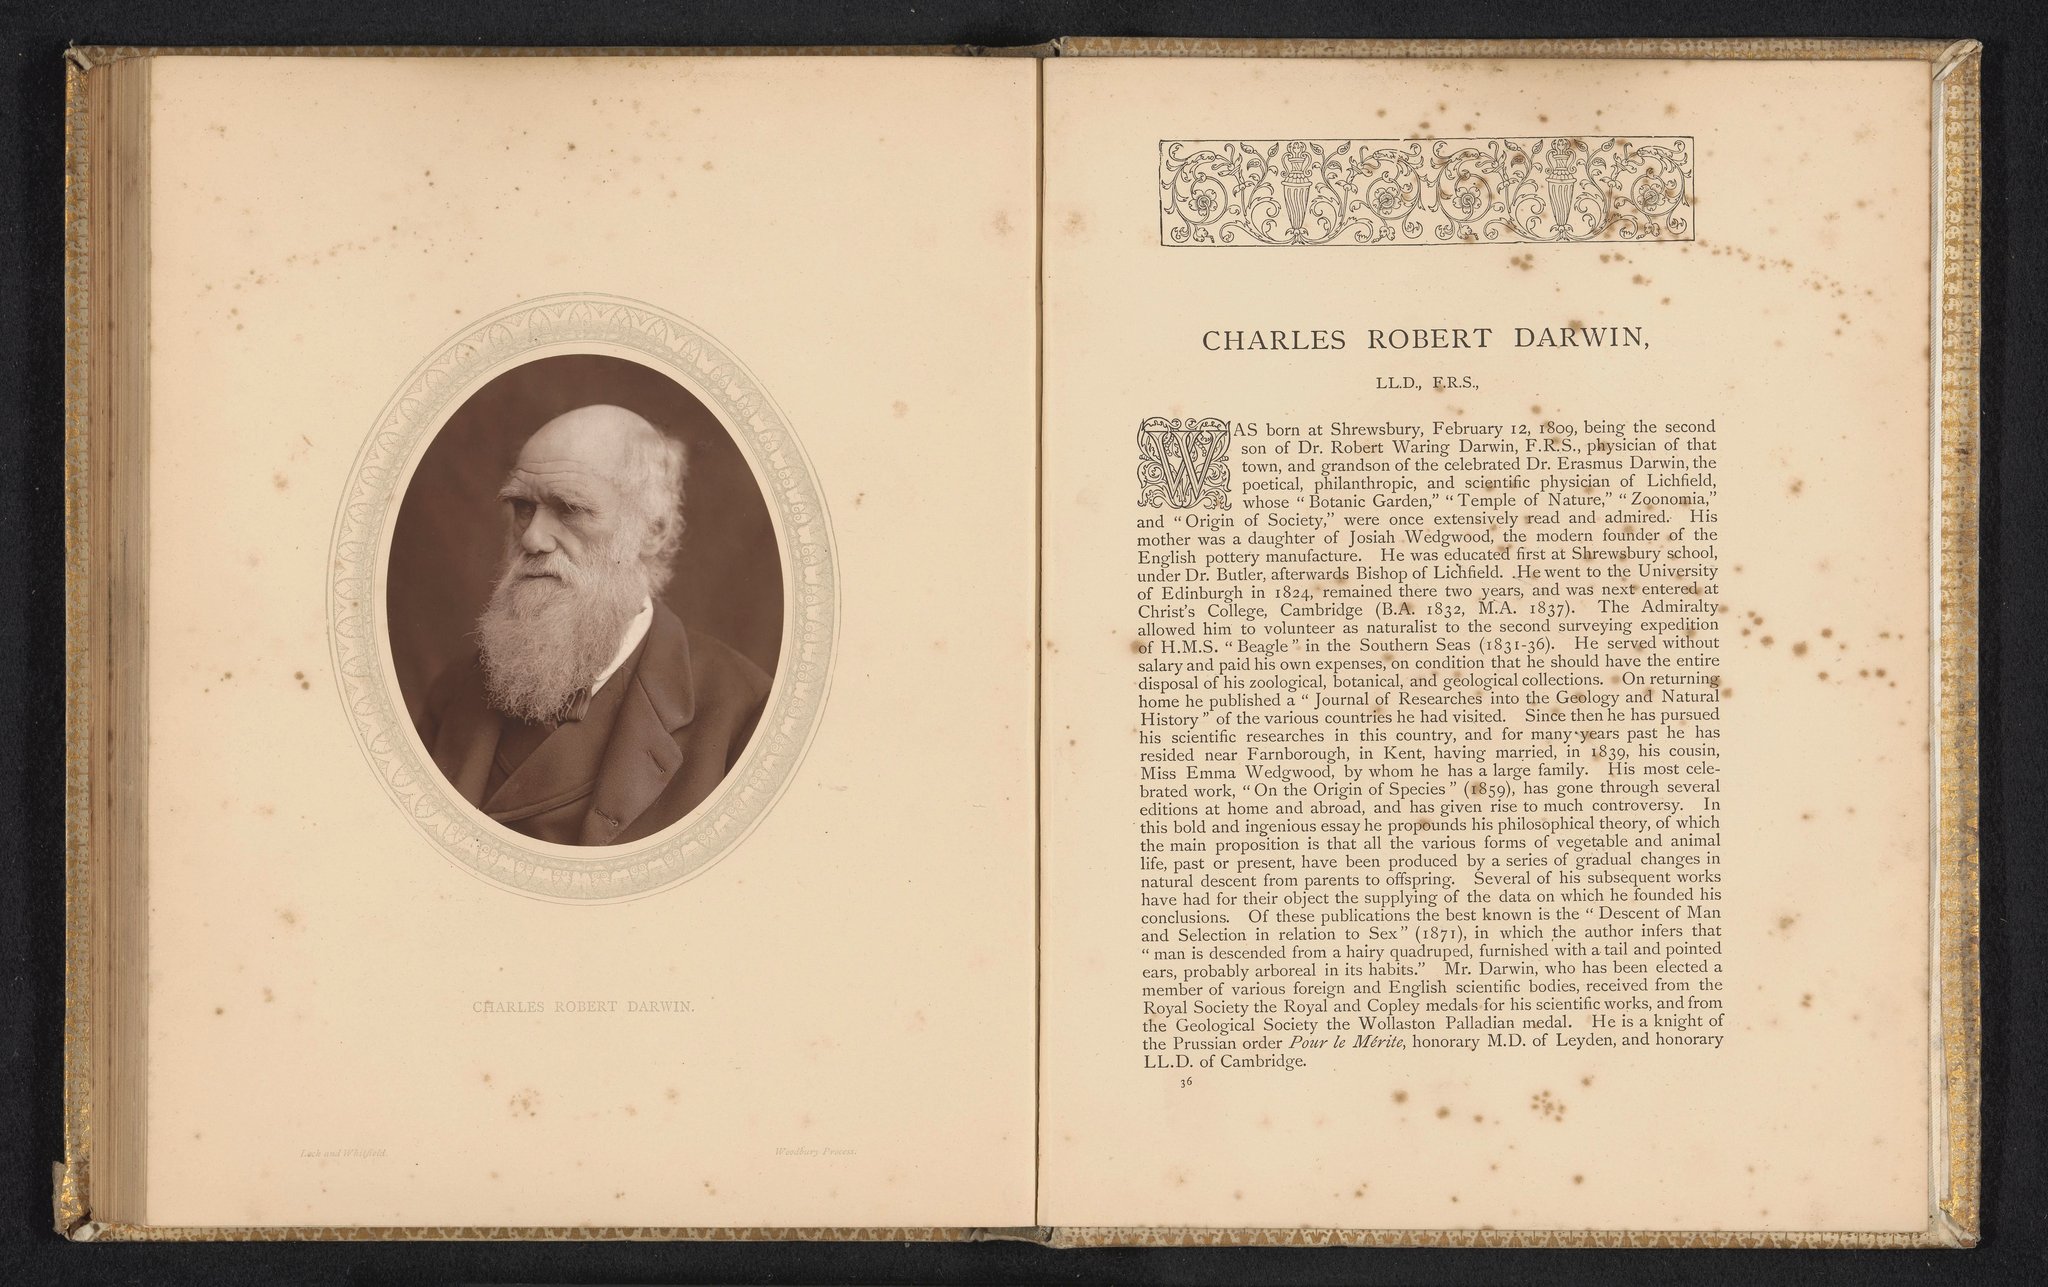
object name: photomechanical print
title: Charles Robert Darwin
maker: Anonymous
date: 1873-1878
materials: paper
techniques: woodburytype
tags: charles darwin, scholar, philosopher, historical persons (portraits and scenes from the life) (+ (full) bust portrait)